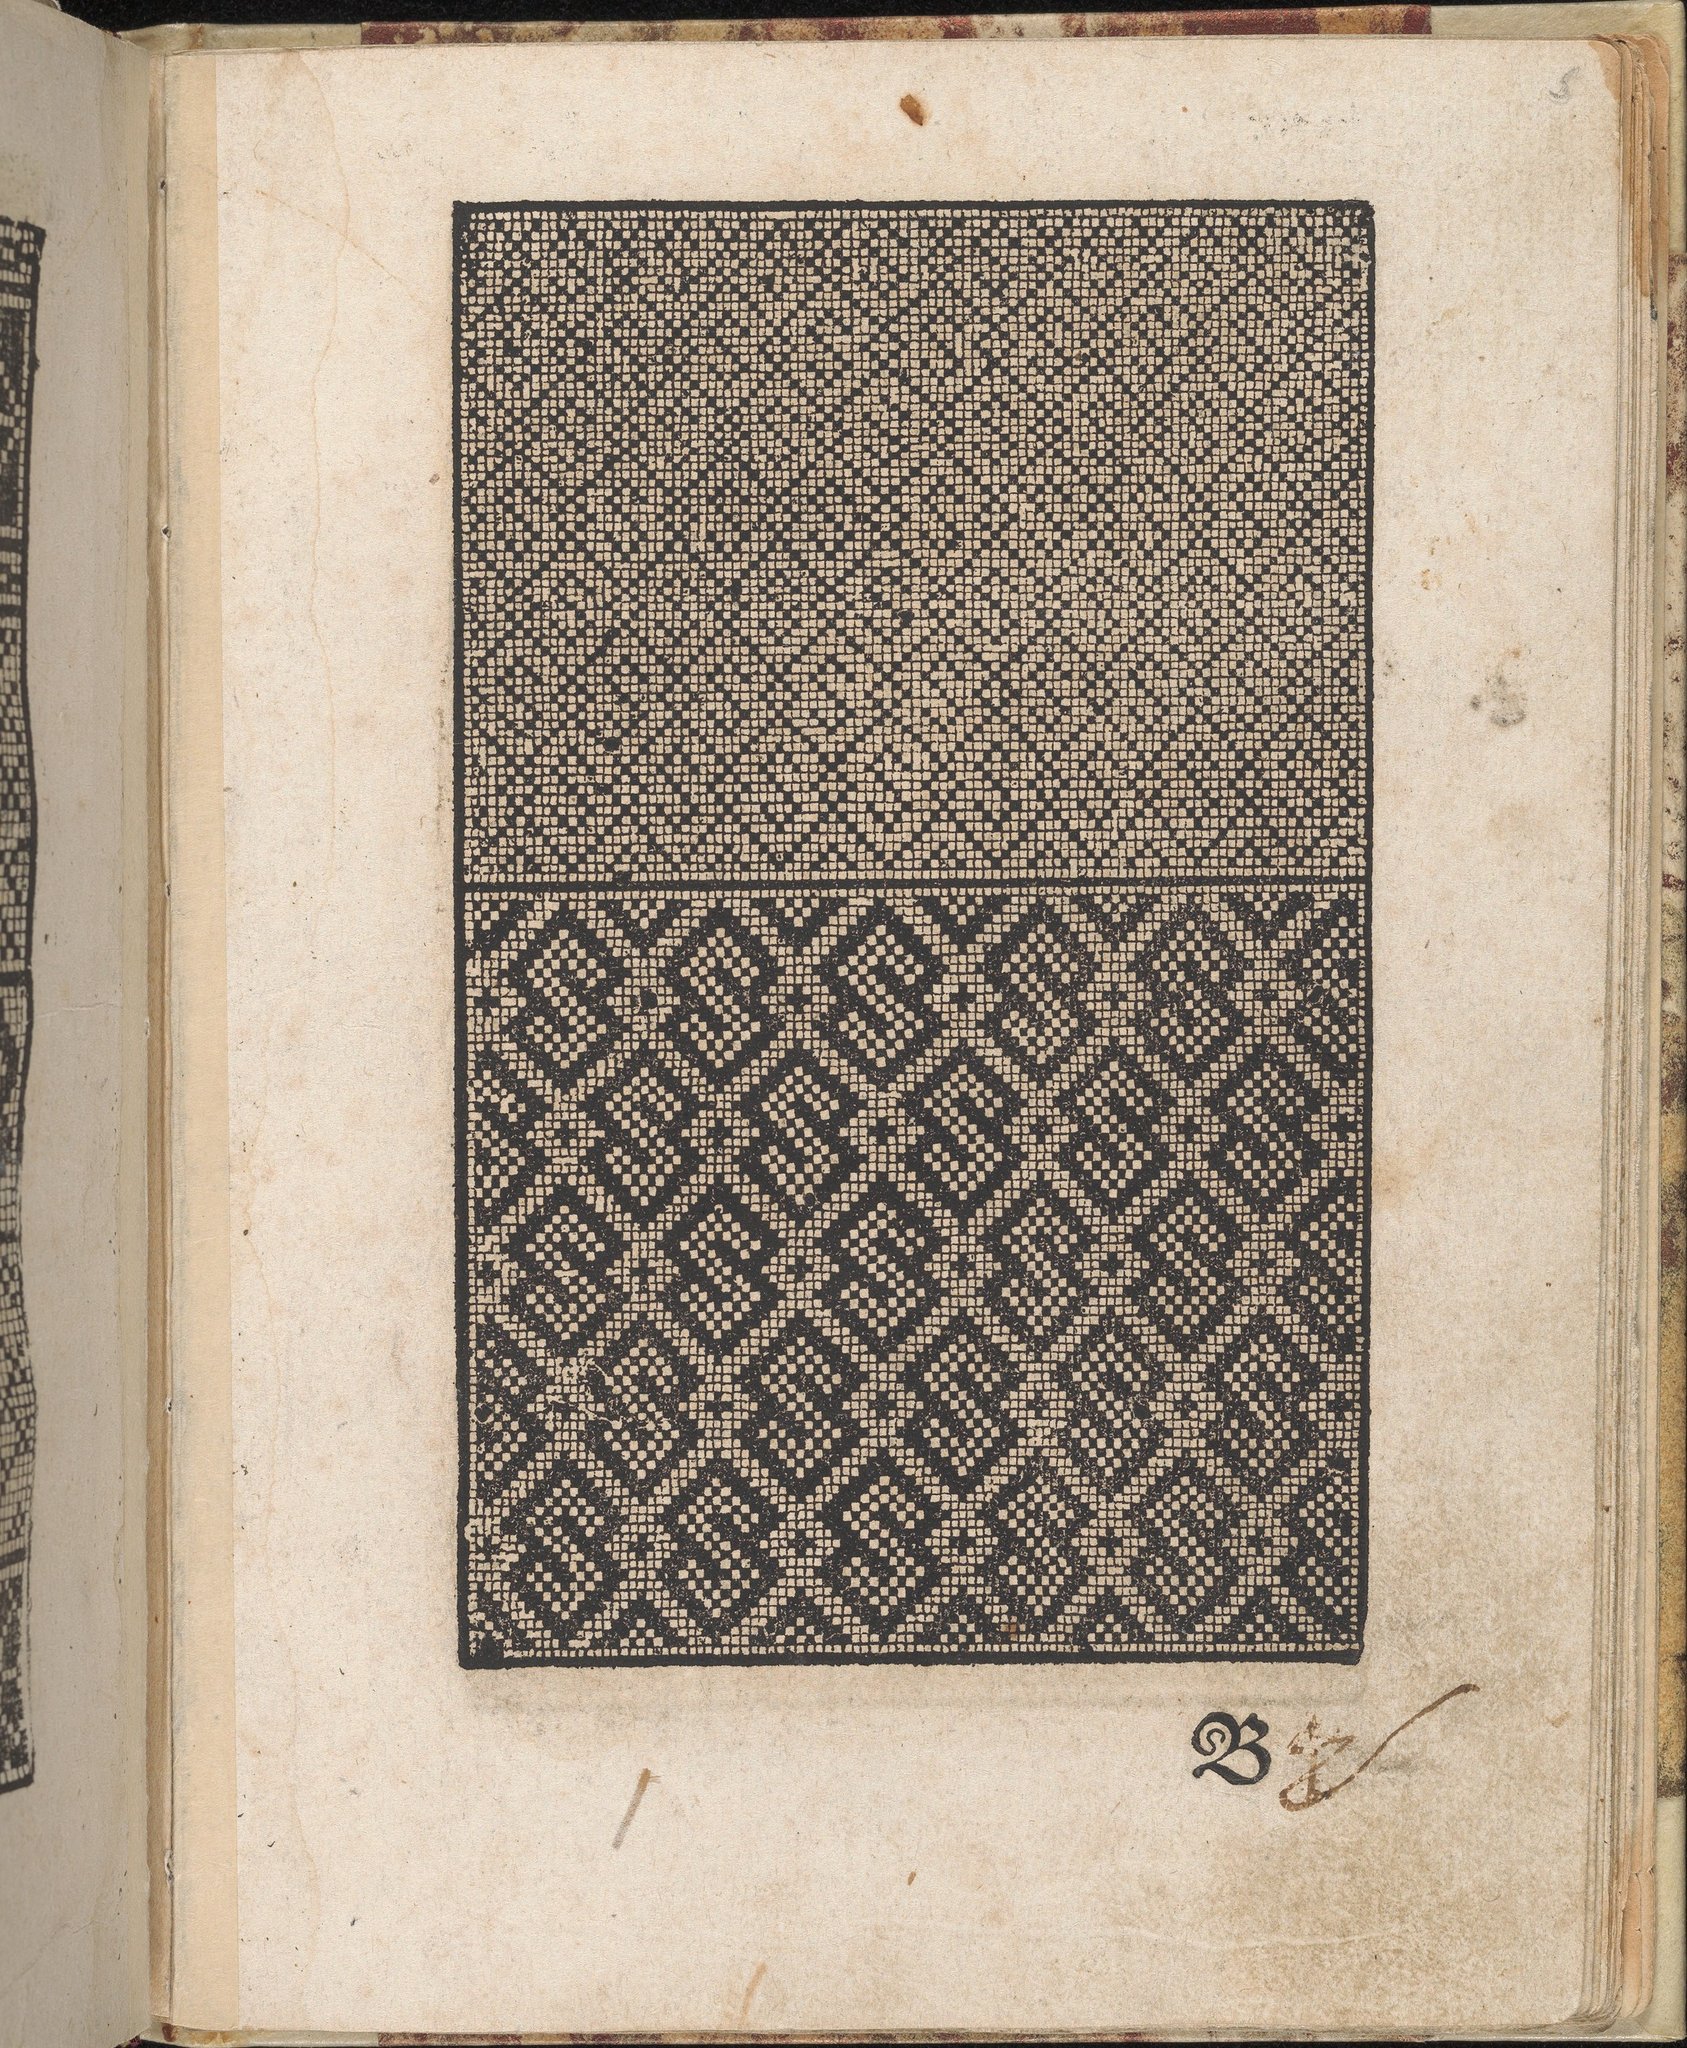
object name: book print ornament architecture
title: Ein new getruckt model Büchli...Page 4, verso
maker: johann schönsperger the younger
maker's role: publisher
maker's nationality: german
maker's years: 1490-1550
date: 1529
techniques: woodcut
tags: ornament